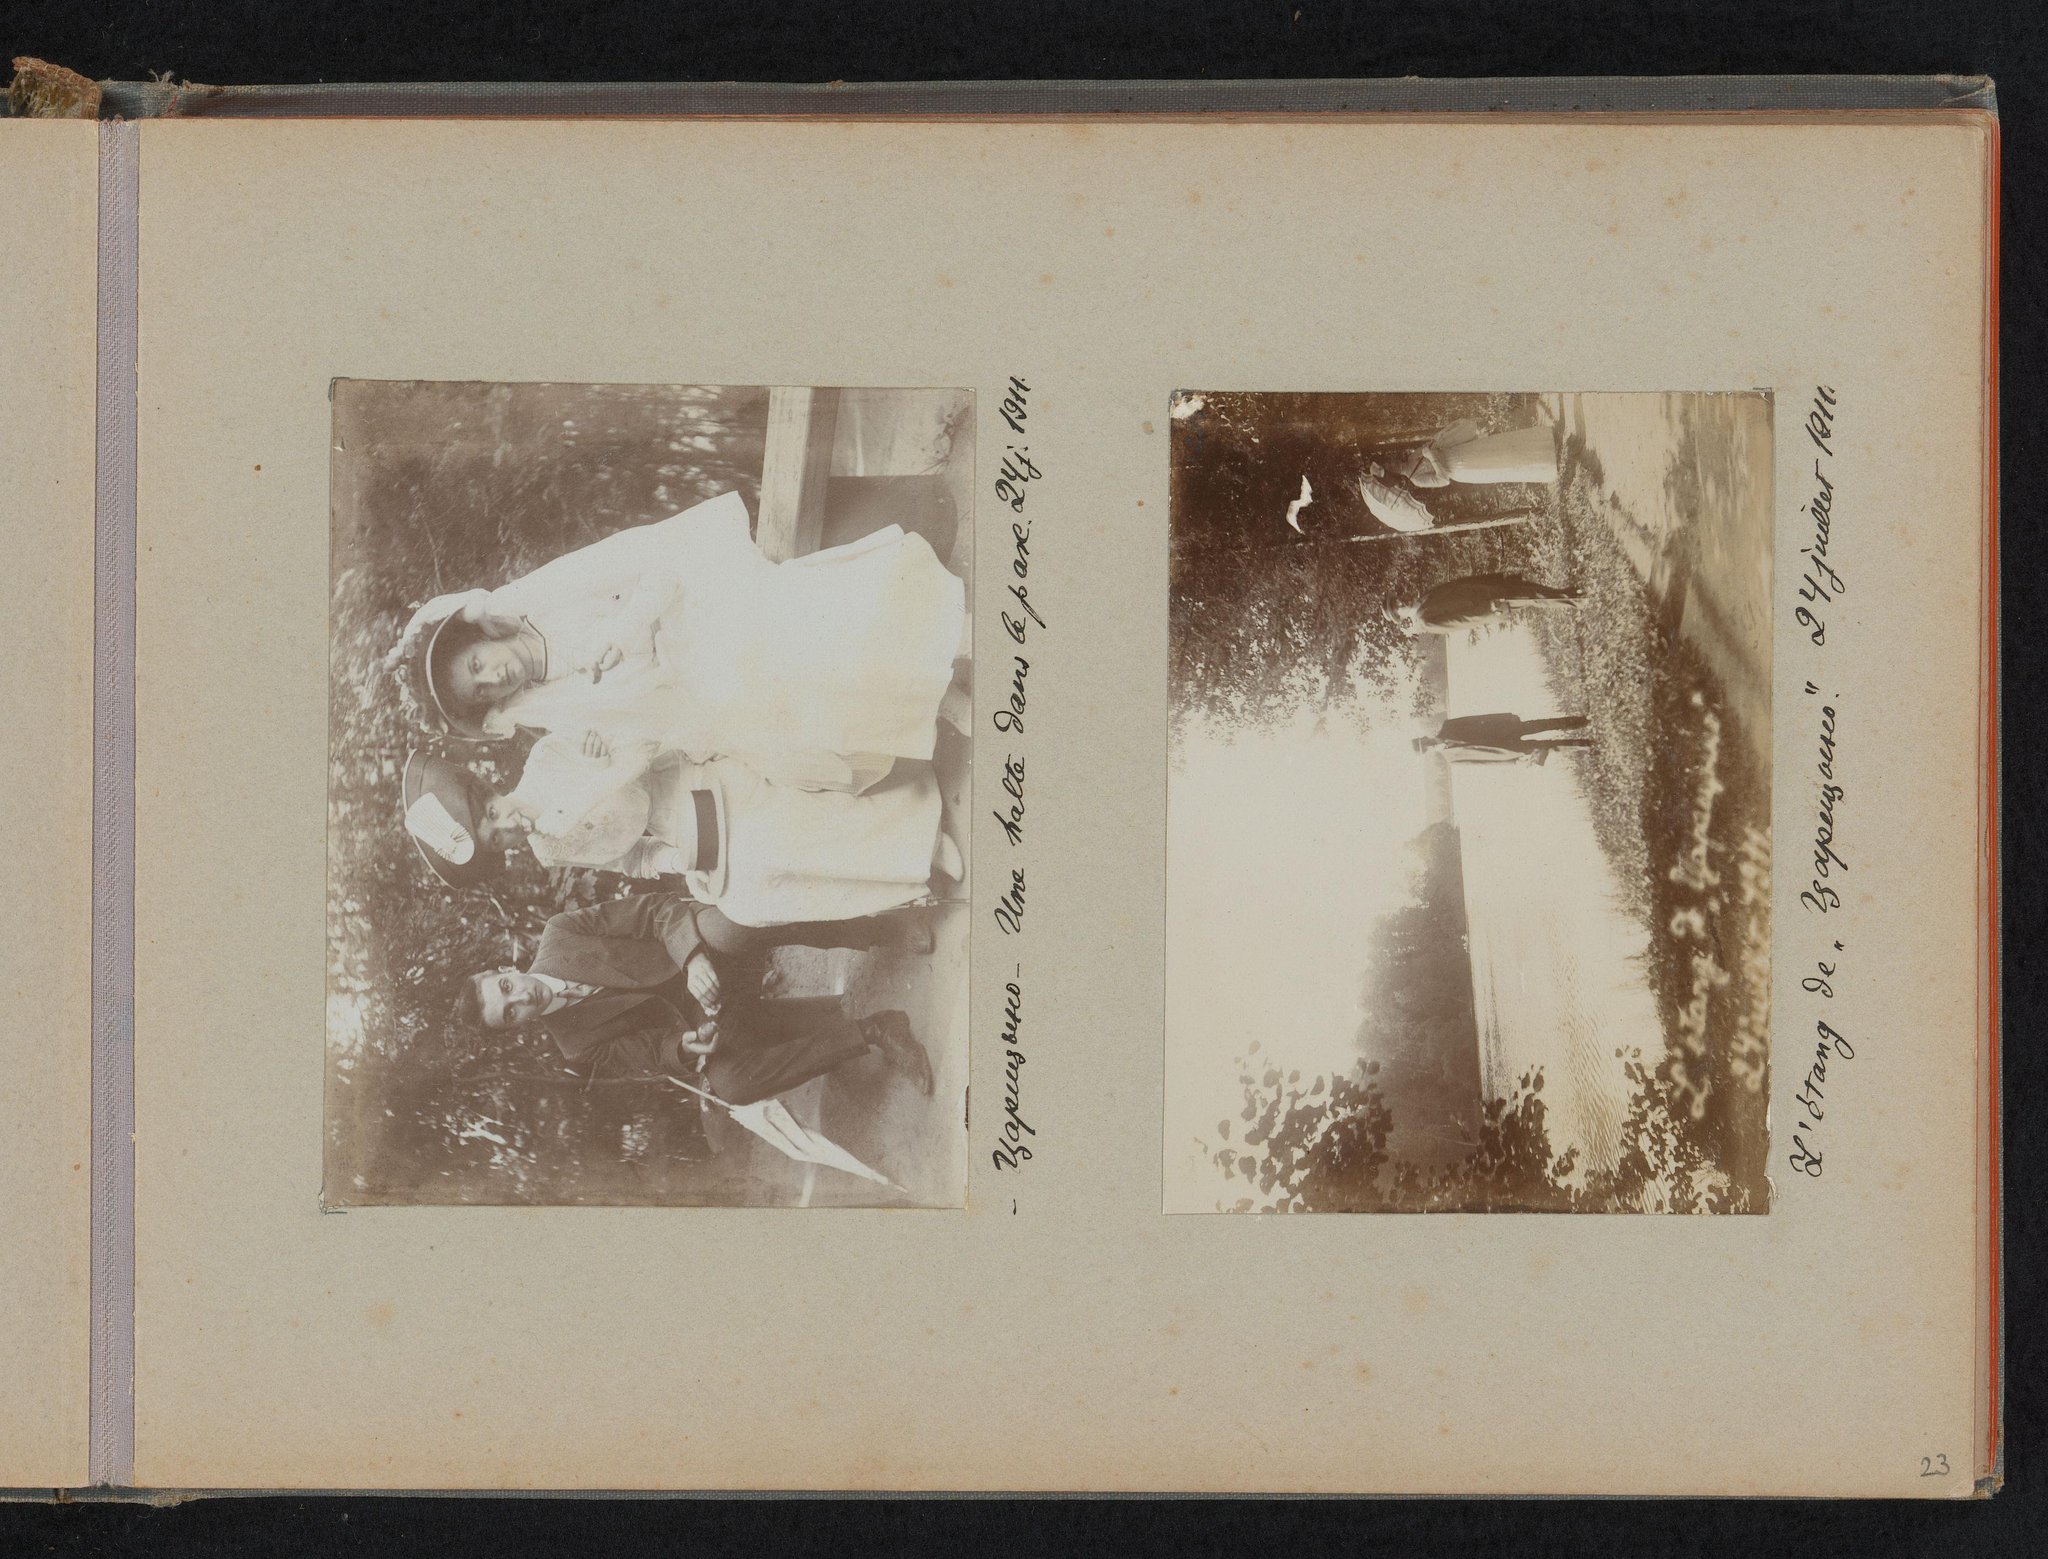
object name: photograph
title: Jongeman en twee vrouwen buiten op een bank en twee mannen en een vrouw bij een meer in het Tsaritsynopark, Moskou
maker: Anonymous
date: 1911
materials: paper, cardboard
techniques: collodion silver print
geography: moscow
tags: bench, historical persons - bb - woman, lake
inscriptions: inscription: ‘- Царицыно - Une halte dans le pase. 24 j. 1911.’, inscription: ‘L'étang le "Царицыно" 24 juillet 1911.’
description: Deze foto's maken deel uit van een album.